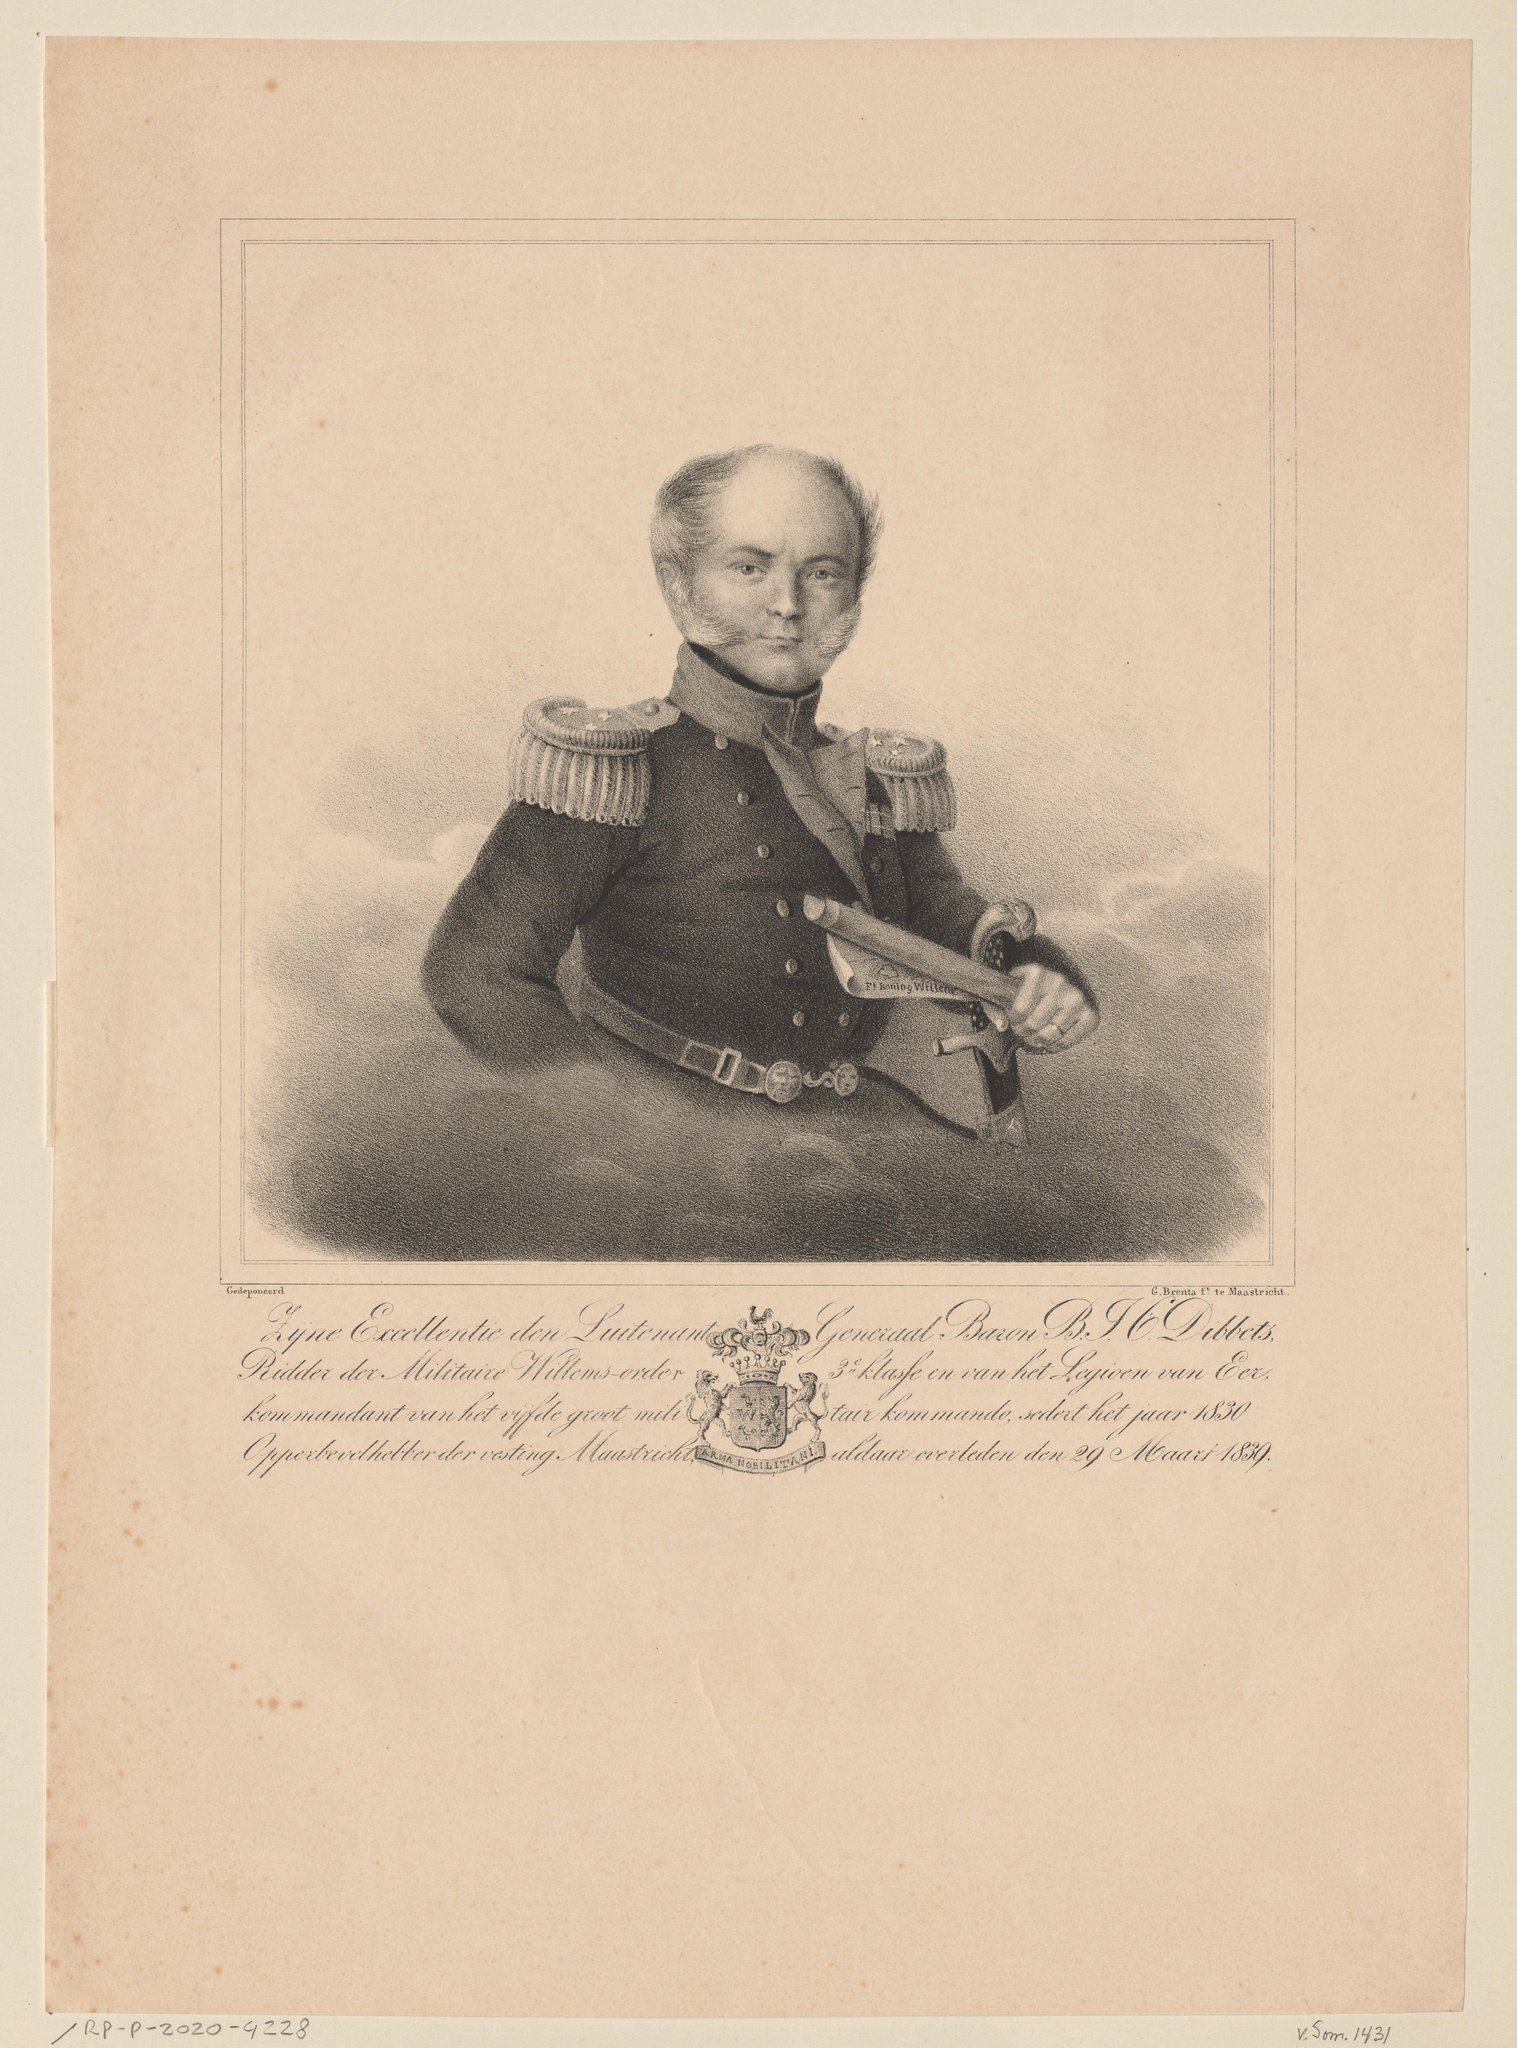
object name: print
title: Portret van baron Bernardus Johannes Cornelis Dibbets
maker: gerardus antonius josephus brenta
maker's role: print maker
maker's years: 1807-1853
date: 1839-1853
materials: paper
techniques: lithograph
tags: arnhem, maastricht, commander-in-chief, general, marshal, historical persons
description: Met in zijn linkerhand het document van de Militaire Willems-Orde.